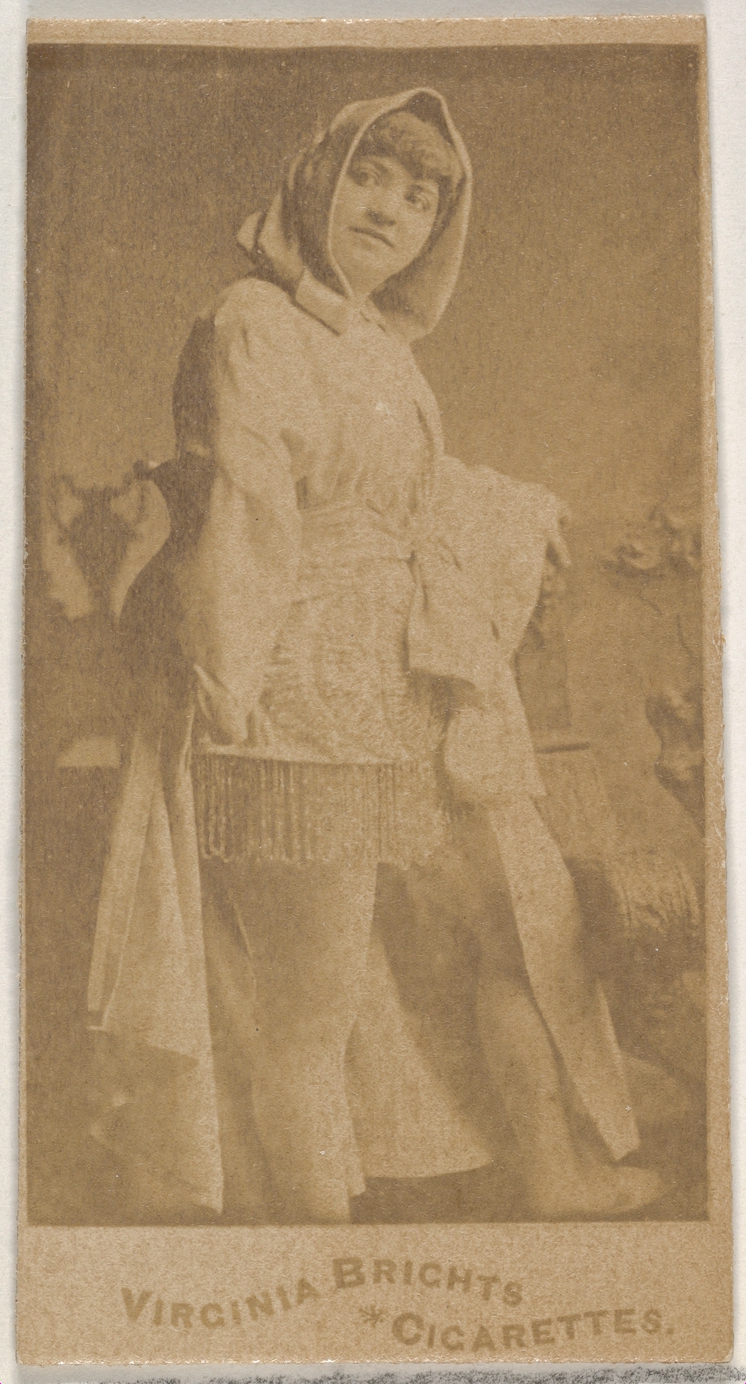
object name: photograph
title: From the Actors and Actresses series (N45, Type 5) for Virginia Brights Cigarettes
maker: allen & ginter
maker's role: publisher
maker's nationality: american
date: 1888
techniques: albumen silver print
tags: portraits,women,actresses